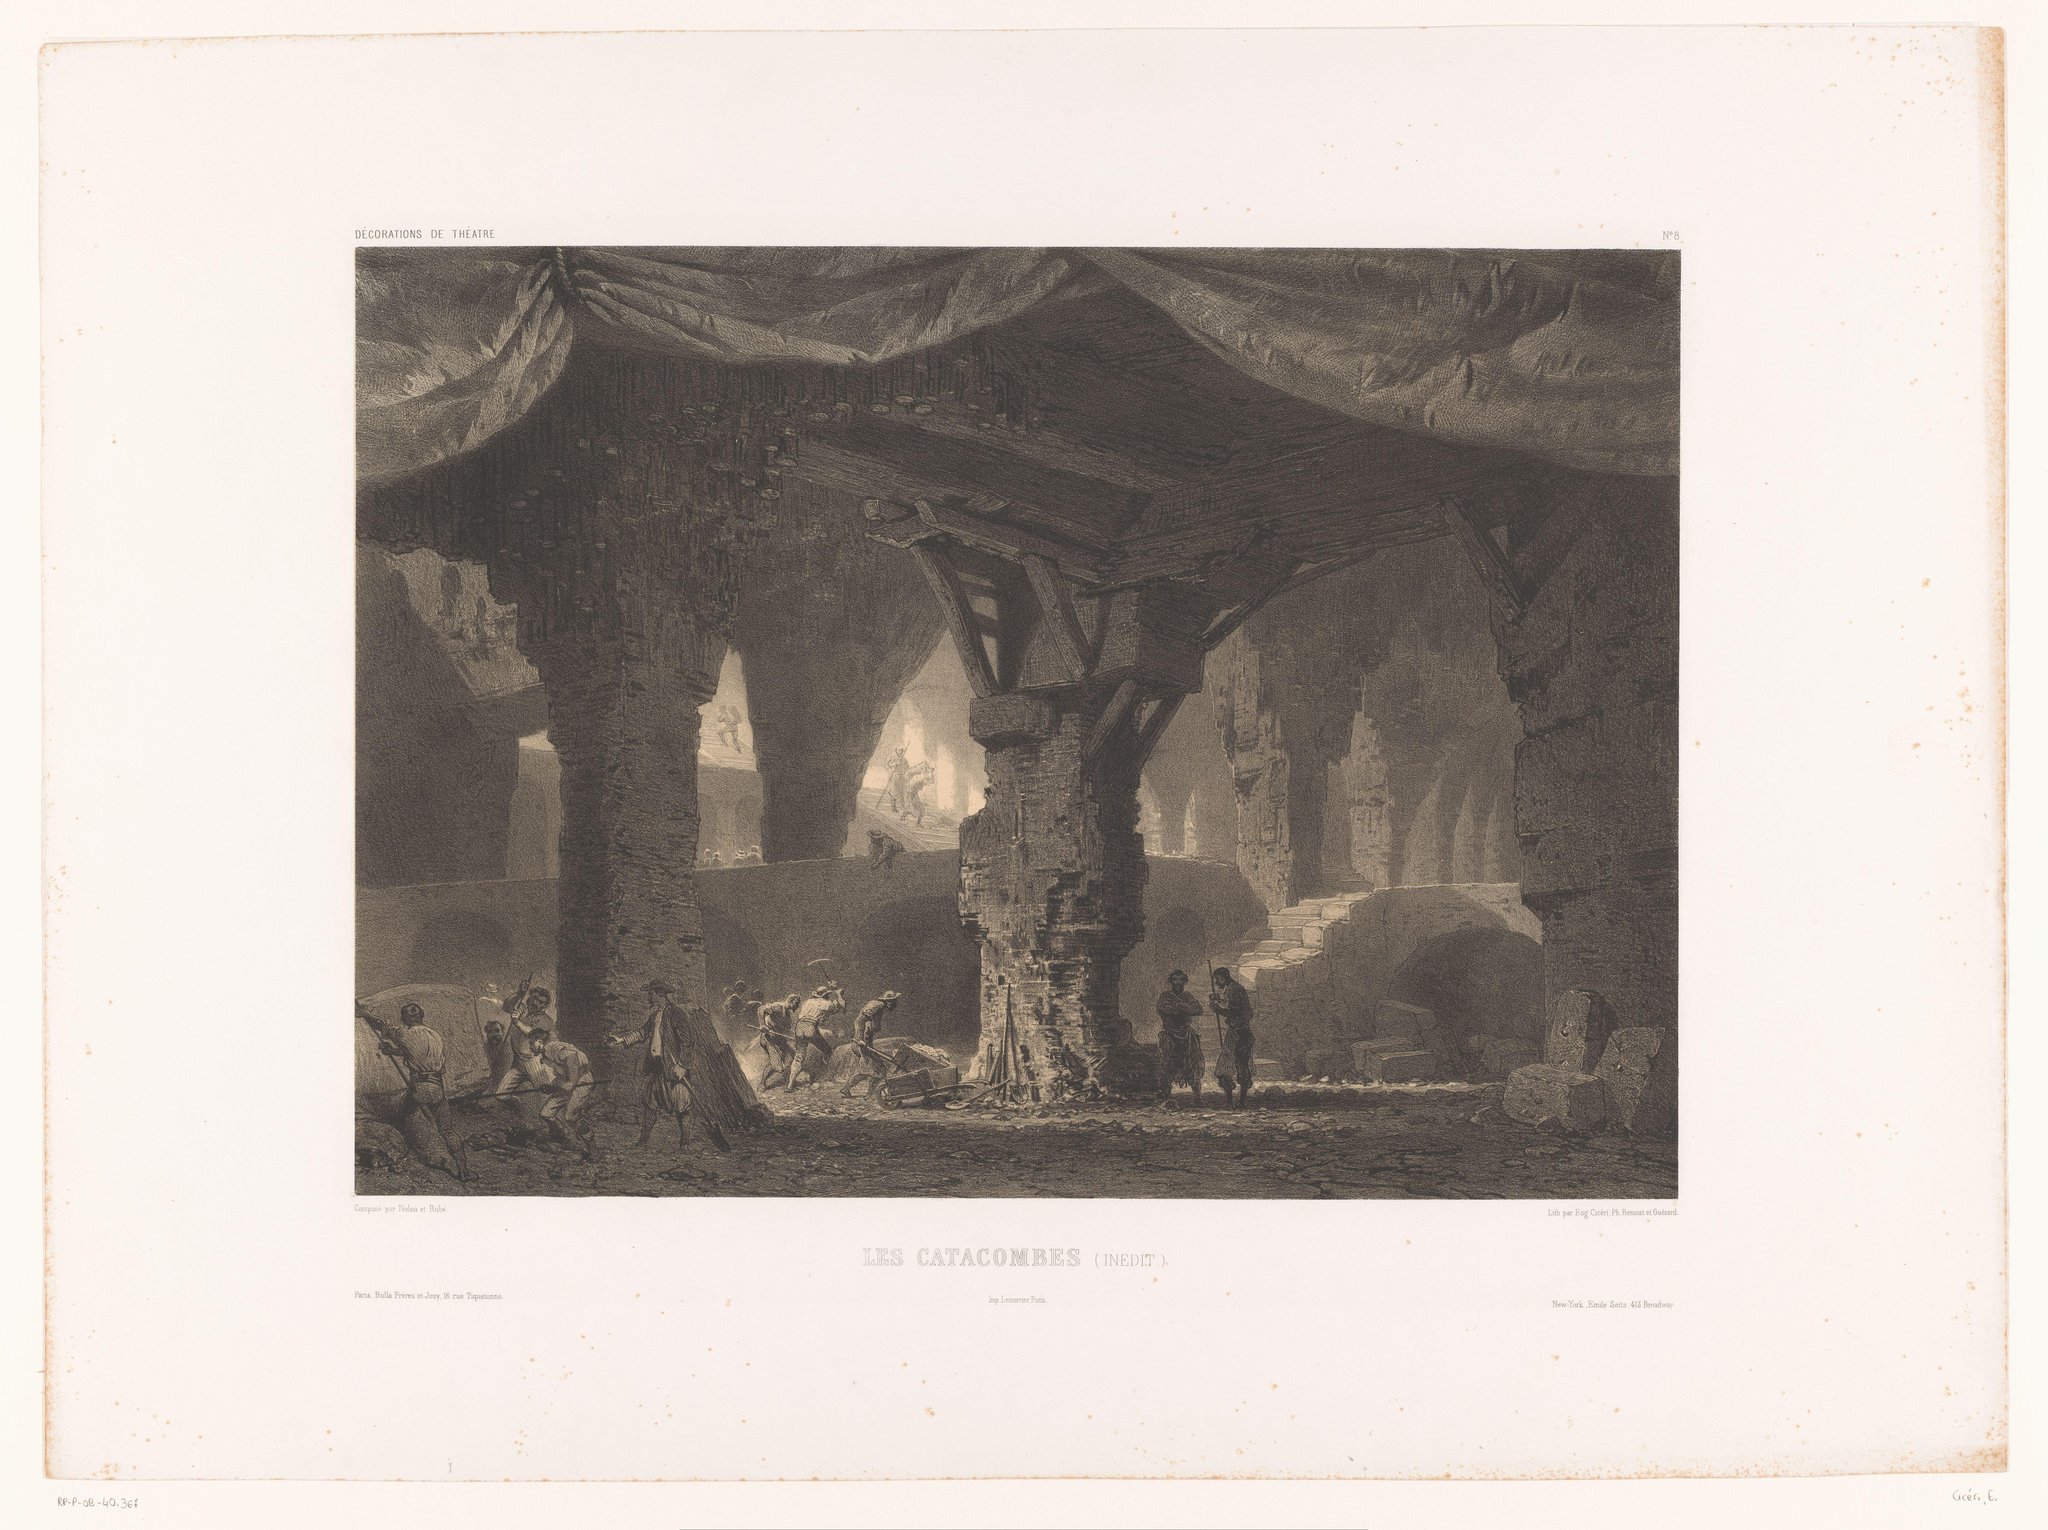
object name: print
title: Décorations de théâtre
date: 1854-1858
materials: paper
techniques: tone lithography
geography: paris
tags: curtains, theatre, theatrical performance, stage design, catacombs, labour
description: Figuren aan het werk met het uithakken van catacomben.